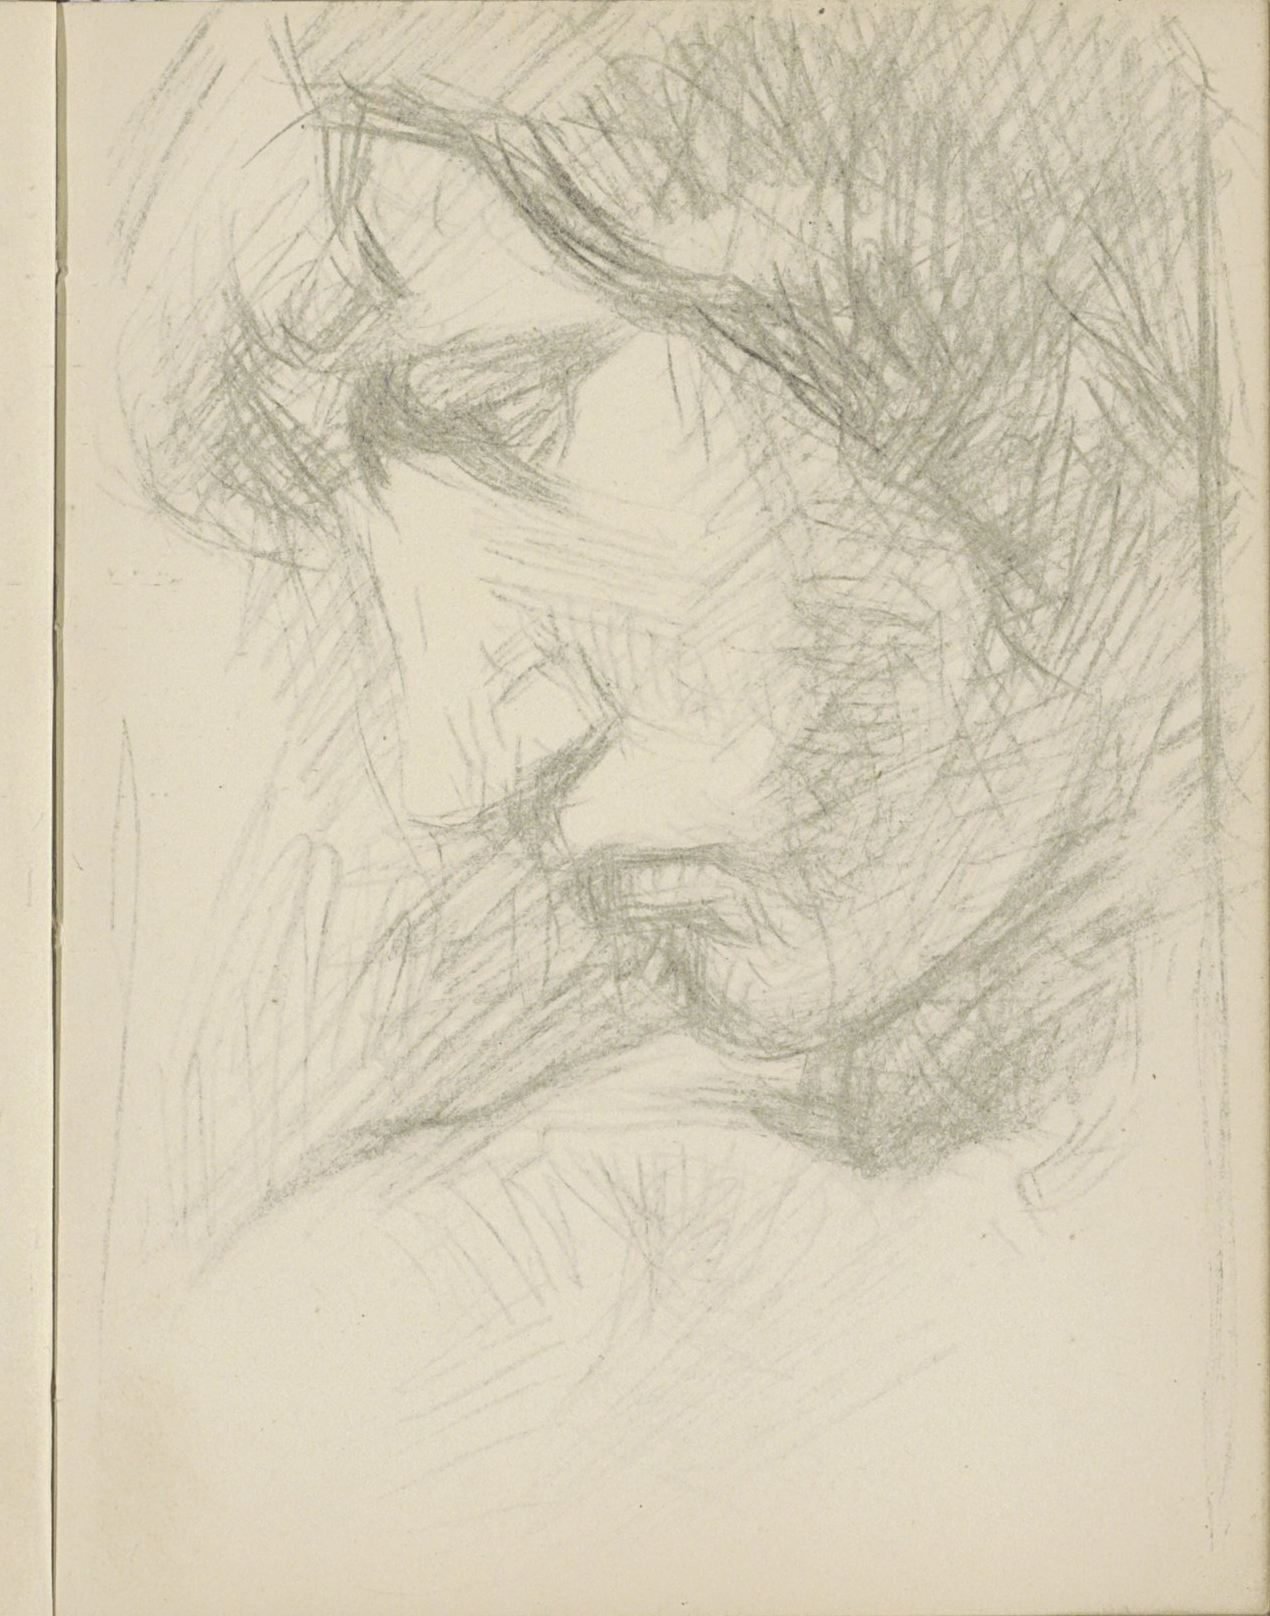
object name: sketchbook leaf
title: Kop van een vrouw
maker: reijer stolk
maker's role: draughtsman, print maker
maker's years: 1896-1945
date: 1906-1945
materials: chalk, paper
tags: head (human) - aa - female human figure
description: Blad 31 recto uit een schetsboek met 69 bladen.